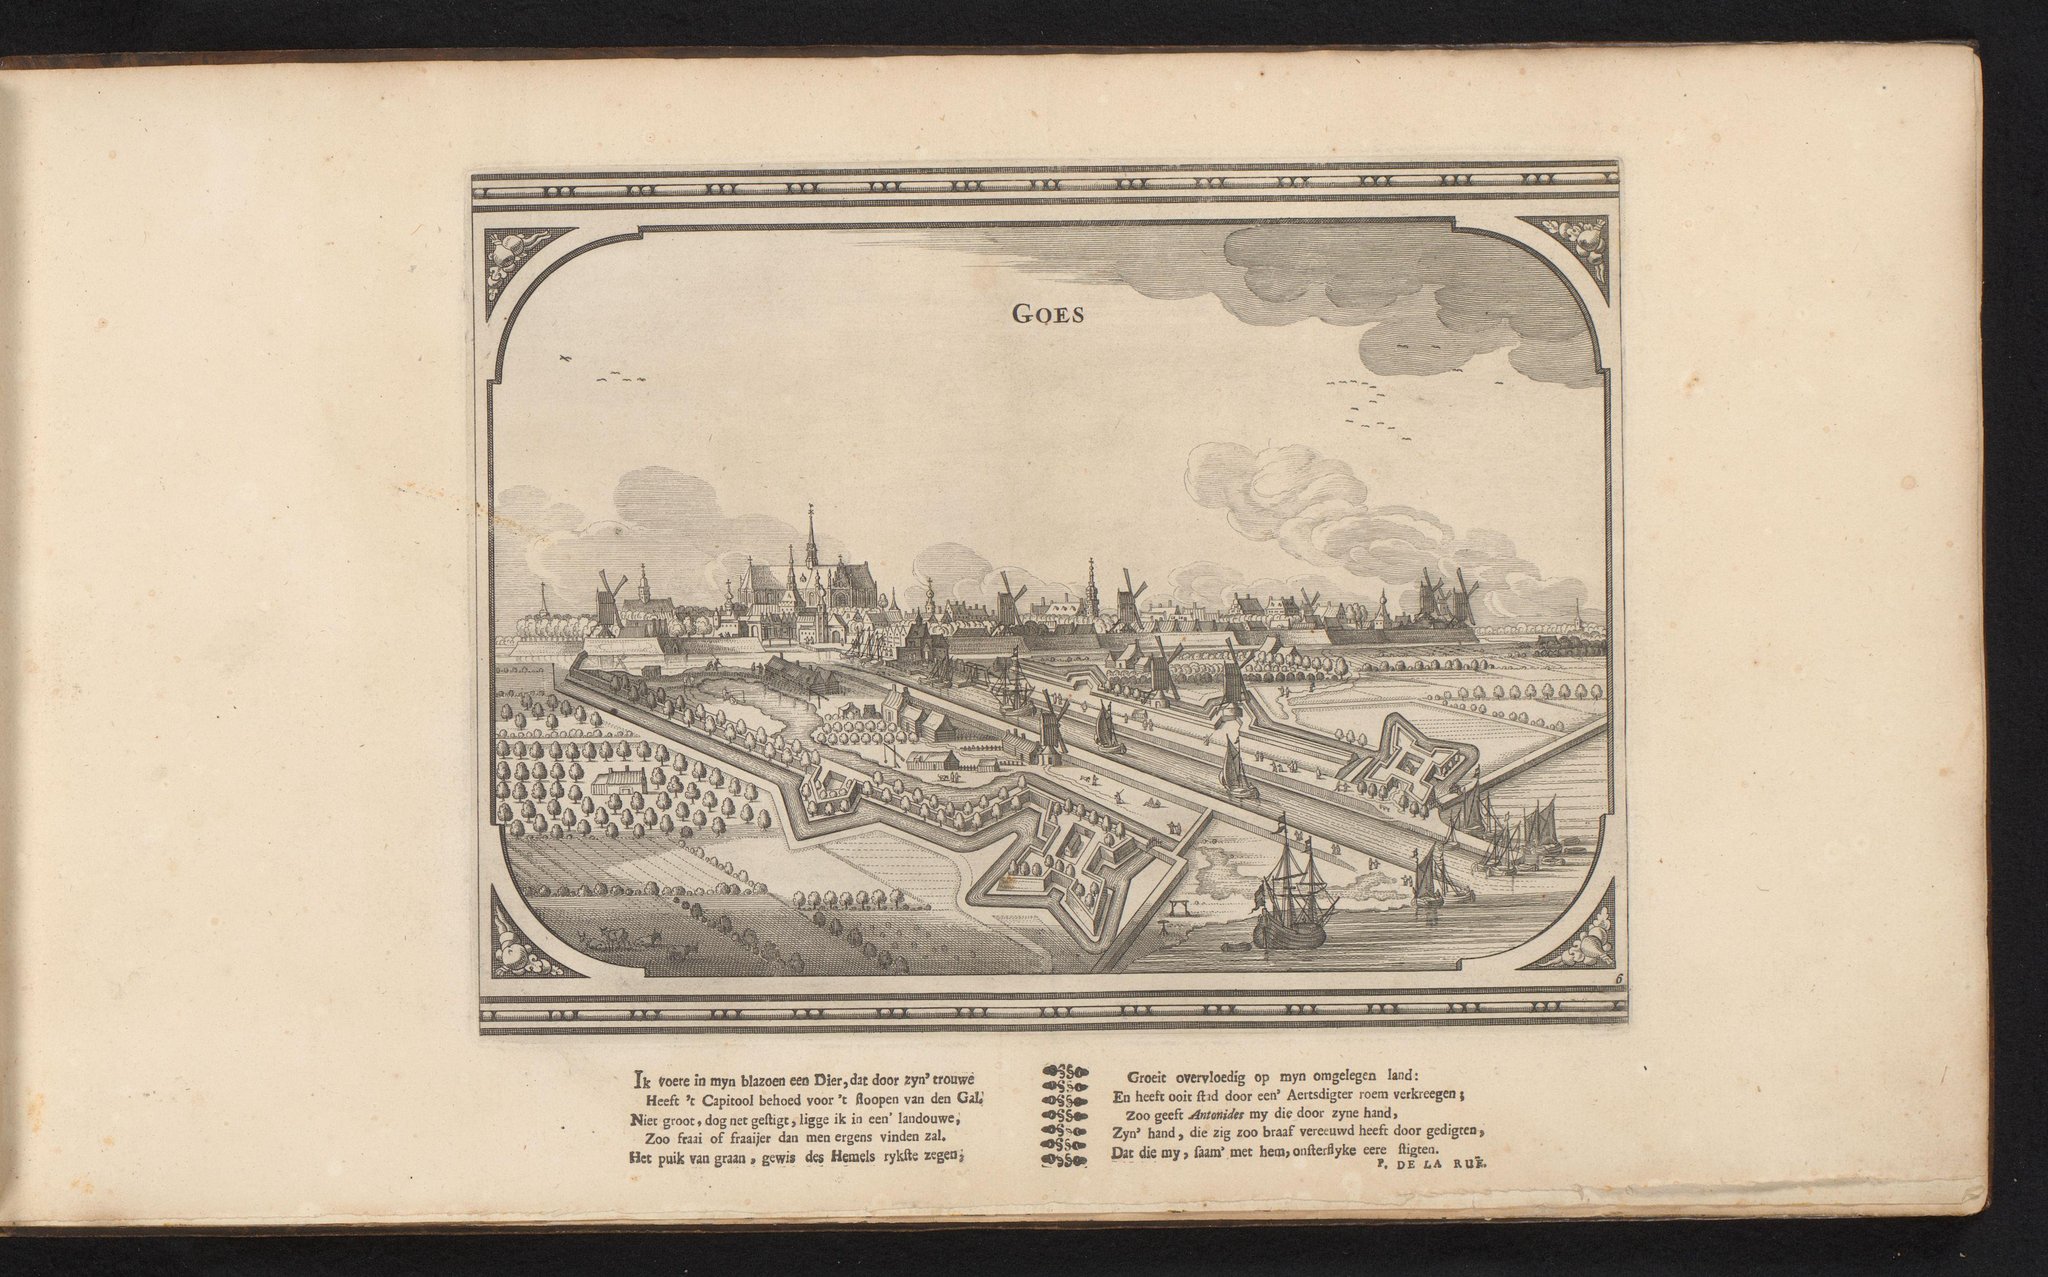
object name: print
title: Speculum Zelandiae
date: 1731-1800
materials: paper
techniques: etching, letterpress printing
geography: middelburg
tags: city-view, and landscape with man-made constructions, canal, factories and mills in landscape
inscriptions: collector's mark: Lugt 195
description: Gezicht op de stad Goes. Op het kanaal naar de stad varen verschillende boten en schepen. Daaronder tien versregels in het Nederlands. De prent maakt deel uit van een album.